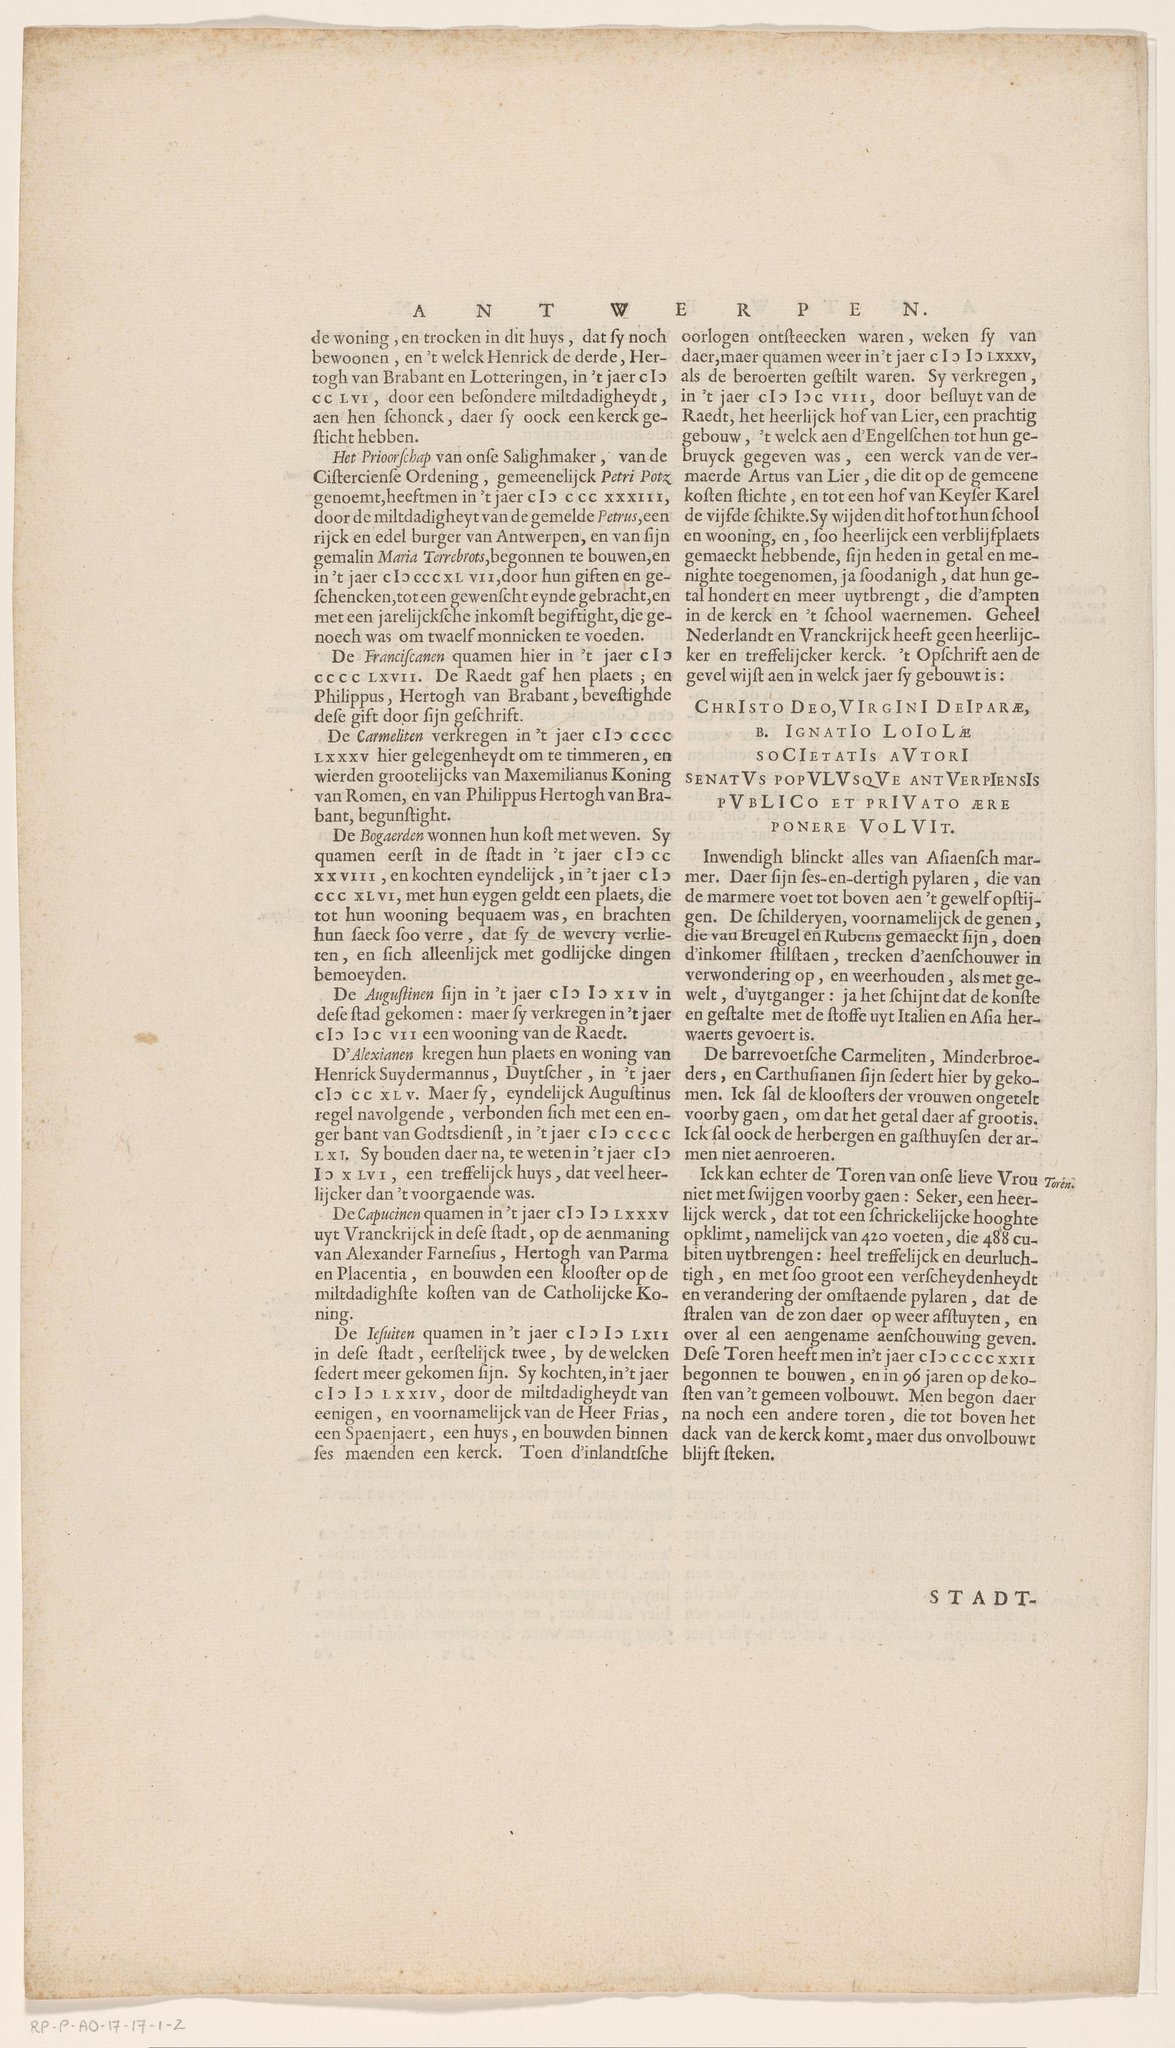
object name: text sheet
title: Deel van de beschrijving van Antwerpen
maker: johannes willemszoon blaeu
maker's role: printer, publisher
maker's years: 1596-1673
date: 1652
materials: paper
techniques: letterpress printing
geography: amsterdam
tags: antwerp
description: Tekst gebruikt in: Blaeu, Johannes Willemszoon. Toonneel der steden van de Vereenighde Nederlanden. 2 delen. Amsterdam: Johannes Willemszoon Blaeu, 1652, dl. 2. Zie ook: RP-P-AO-17-17-1-1.